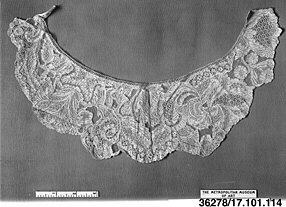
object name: sleeve piece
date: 1701-1800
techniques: lace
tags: flowers